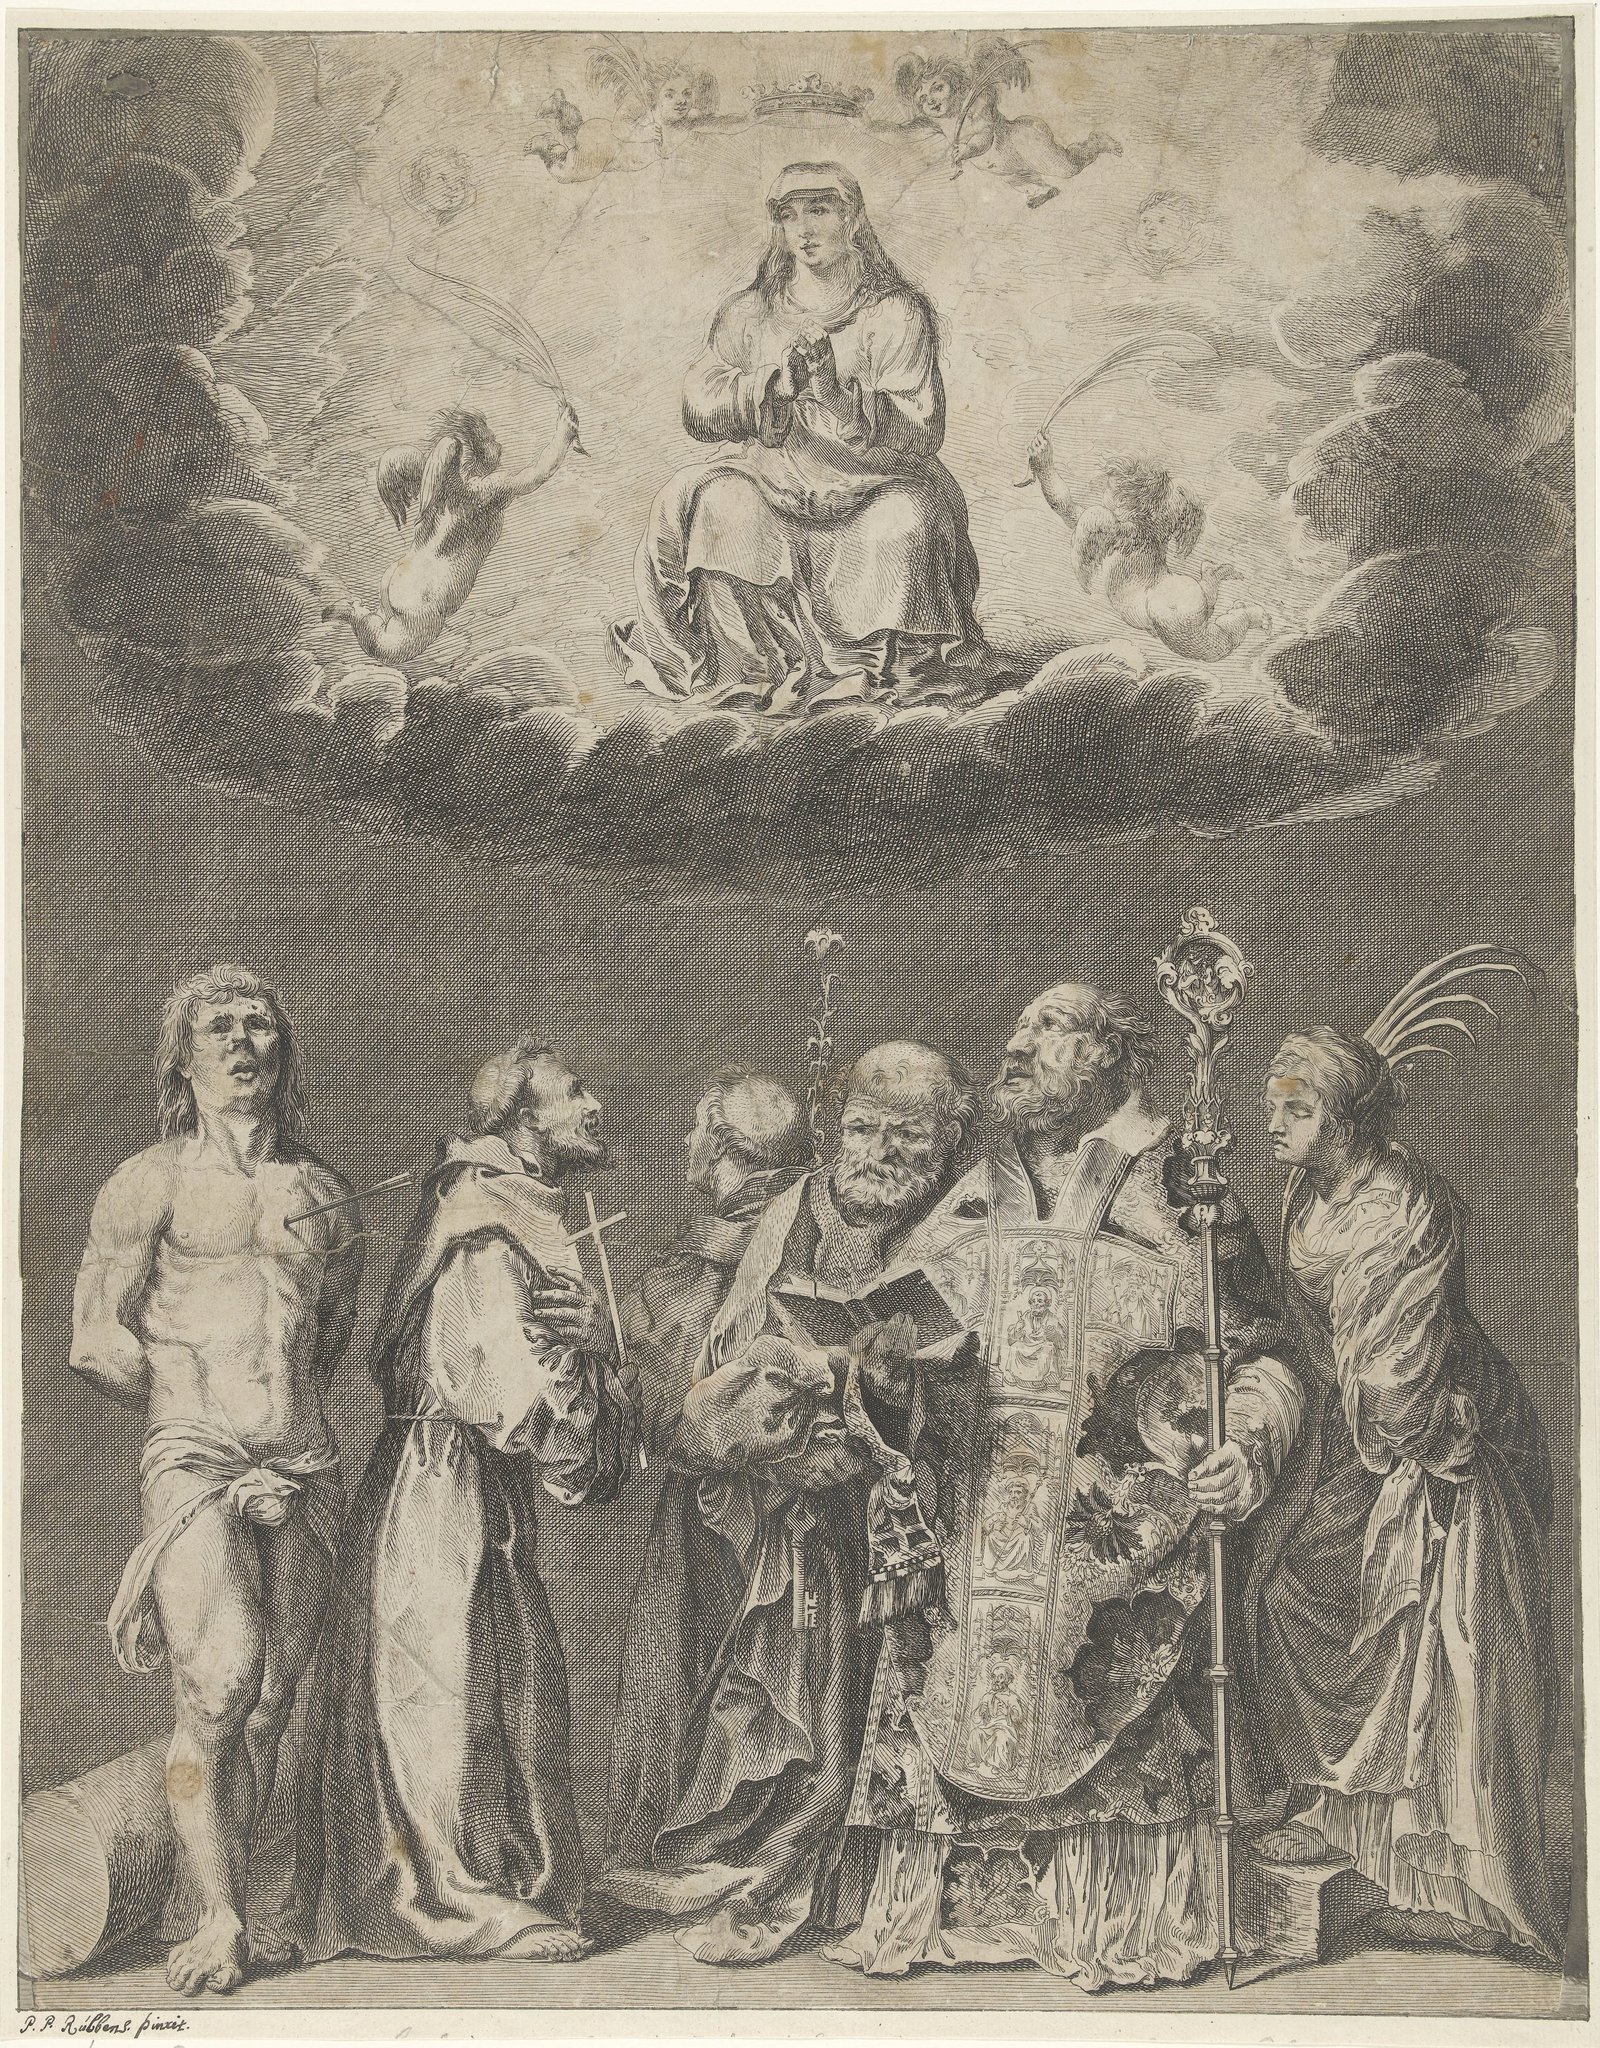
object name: print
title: Maria met heiligen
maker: pieter nolpe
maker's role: draughtsman, print maker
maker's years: 1613-1653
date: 1623-1653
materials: paper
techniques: engraving, etching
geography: amsterdam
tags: madonna (i.e. mary with the christ-child) in the air, or on the clouds (+ angel(s)), the martyr sebastian; possible attributes: arrow(s), bow, tree-trunk, saints, the apostle peter, first bishop of rome; possible attributes: book, cock, (upturned) cross, (triple) crozier, fish, key, scroll, ship, tiara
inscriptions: collector's mark: Lugt 240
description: Op de wolken zit Maria, waar zij wordt gekroond en geflankeerd door cherubijnen en putti met palmtakken. Zij wordt aanbeden door vijf mannelijke heiligen en een vrouwelijke heilige. Onder hen zijn de heilige Sebastiaan met een pijl in zijn borst en Petrus met zijn sleutel.